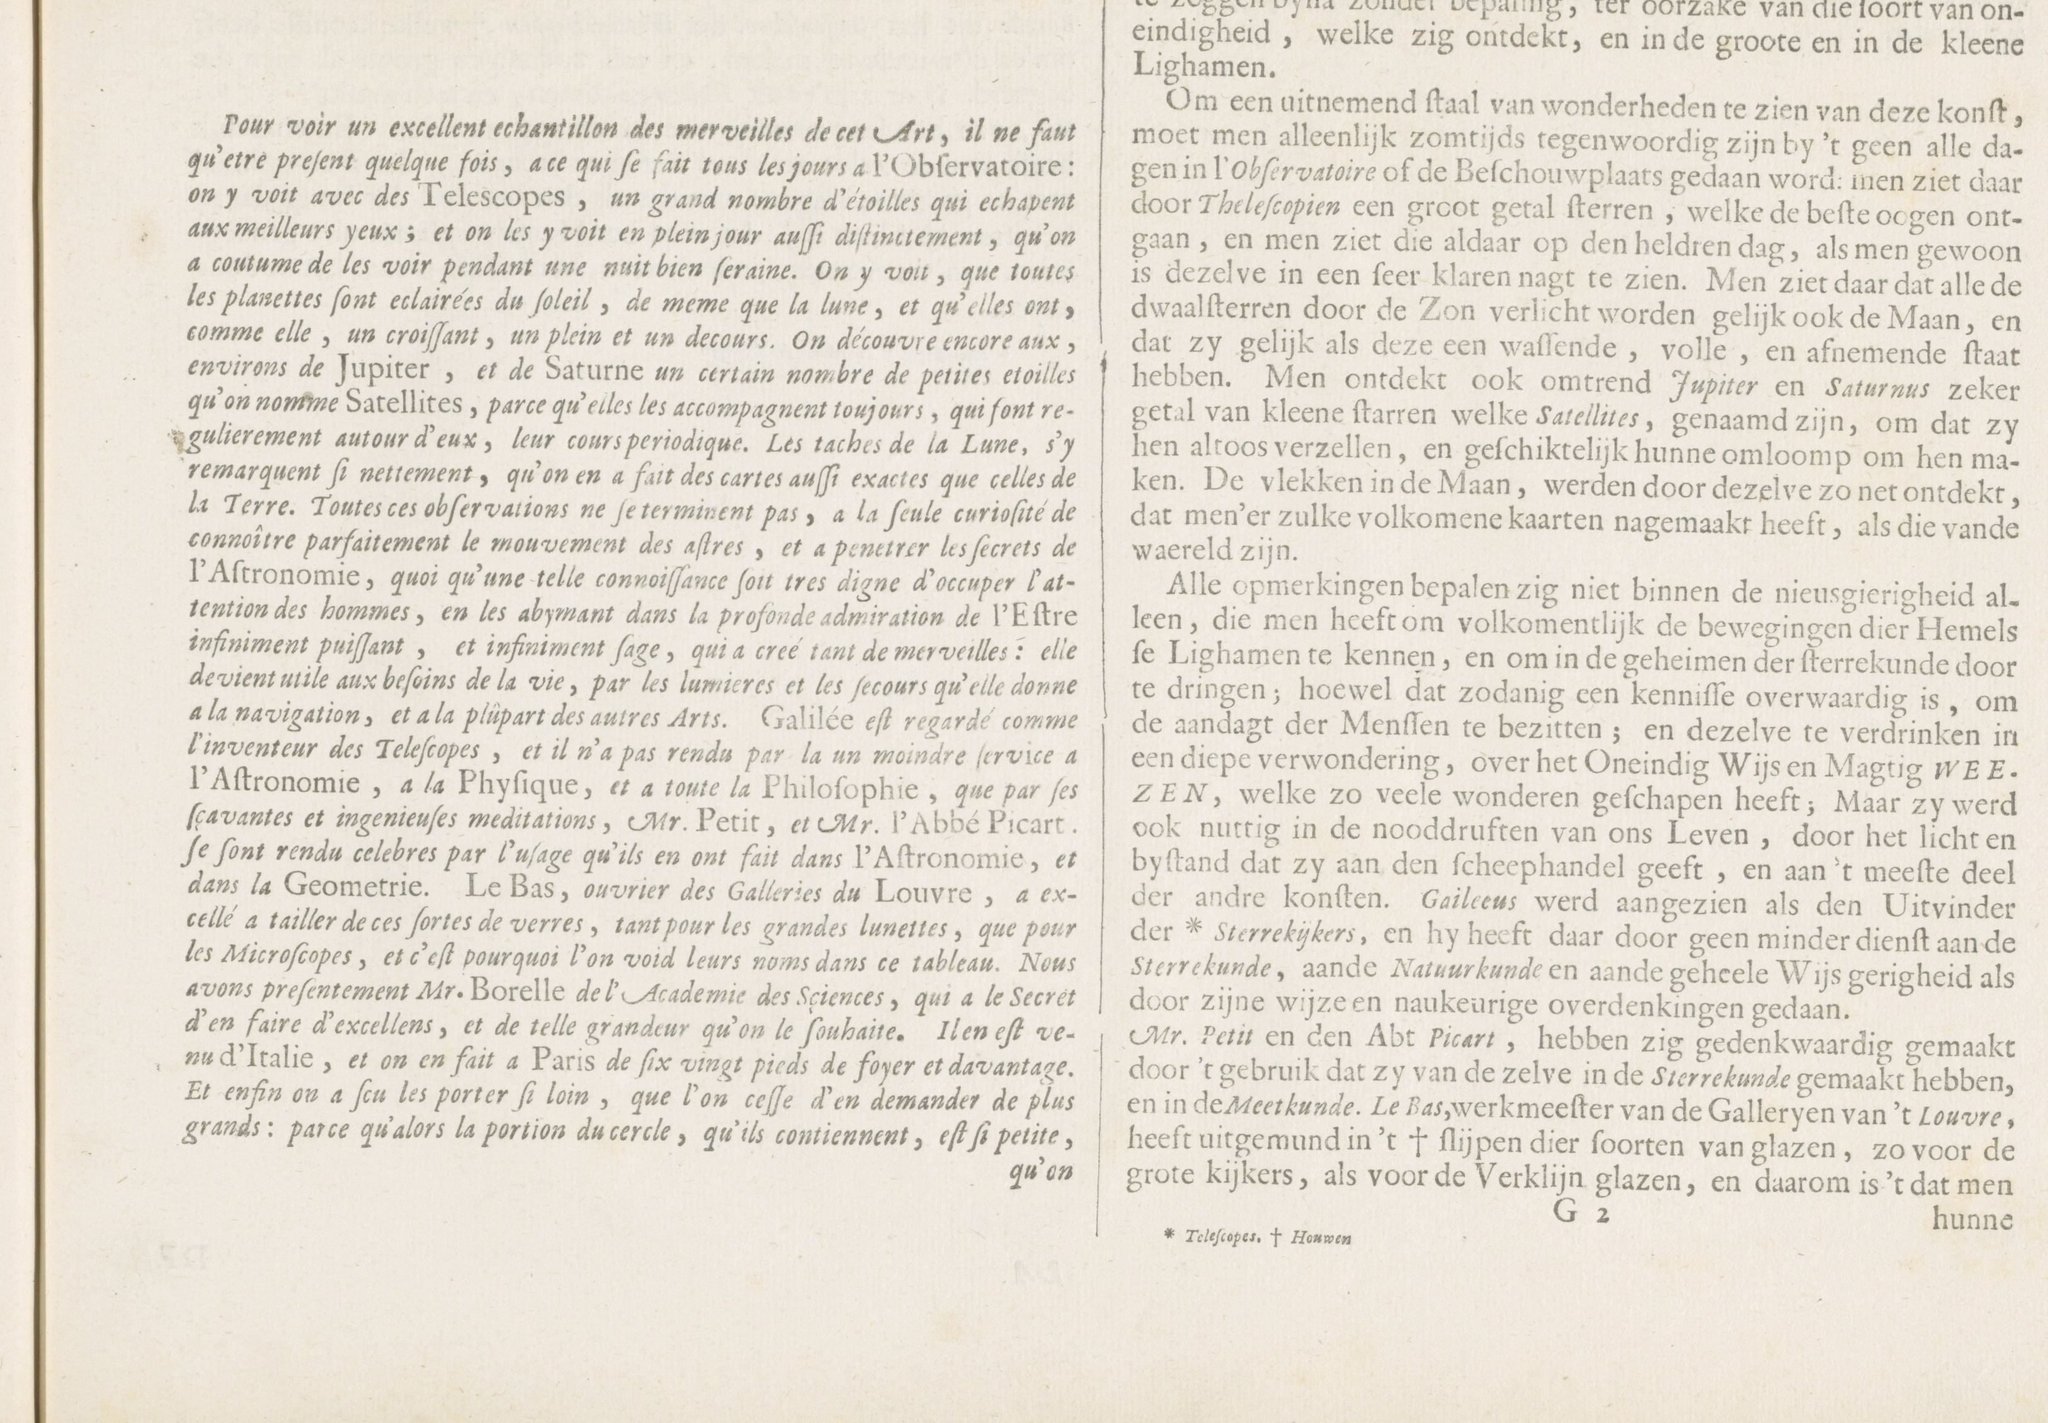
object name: text sheet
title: Tekstblad over de Zichtkunde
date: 1693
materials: paper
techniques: letterpress printing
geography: amsterdam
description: Verklaring van de prent met de voorstelling van de personificatie van Zichtkunde in het Frans en het Nederlands, pagina 27. Tekstblad maakt deel uit van een album.